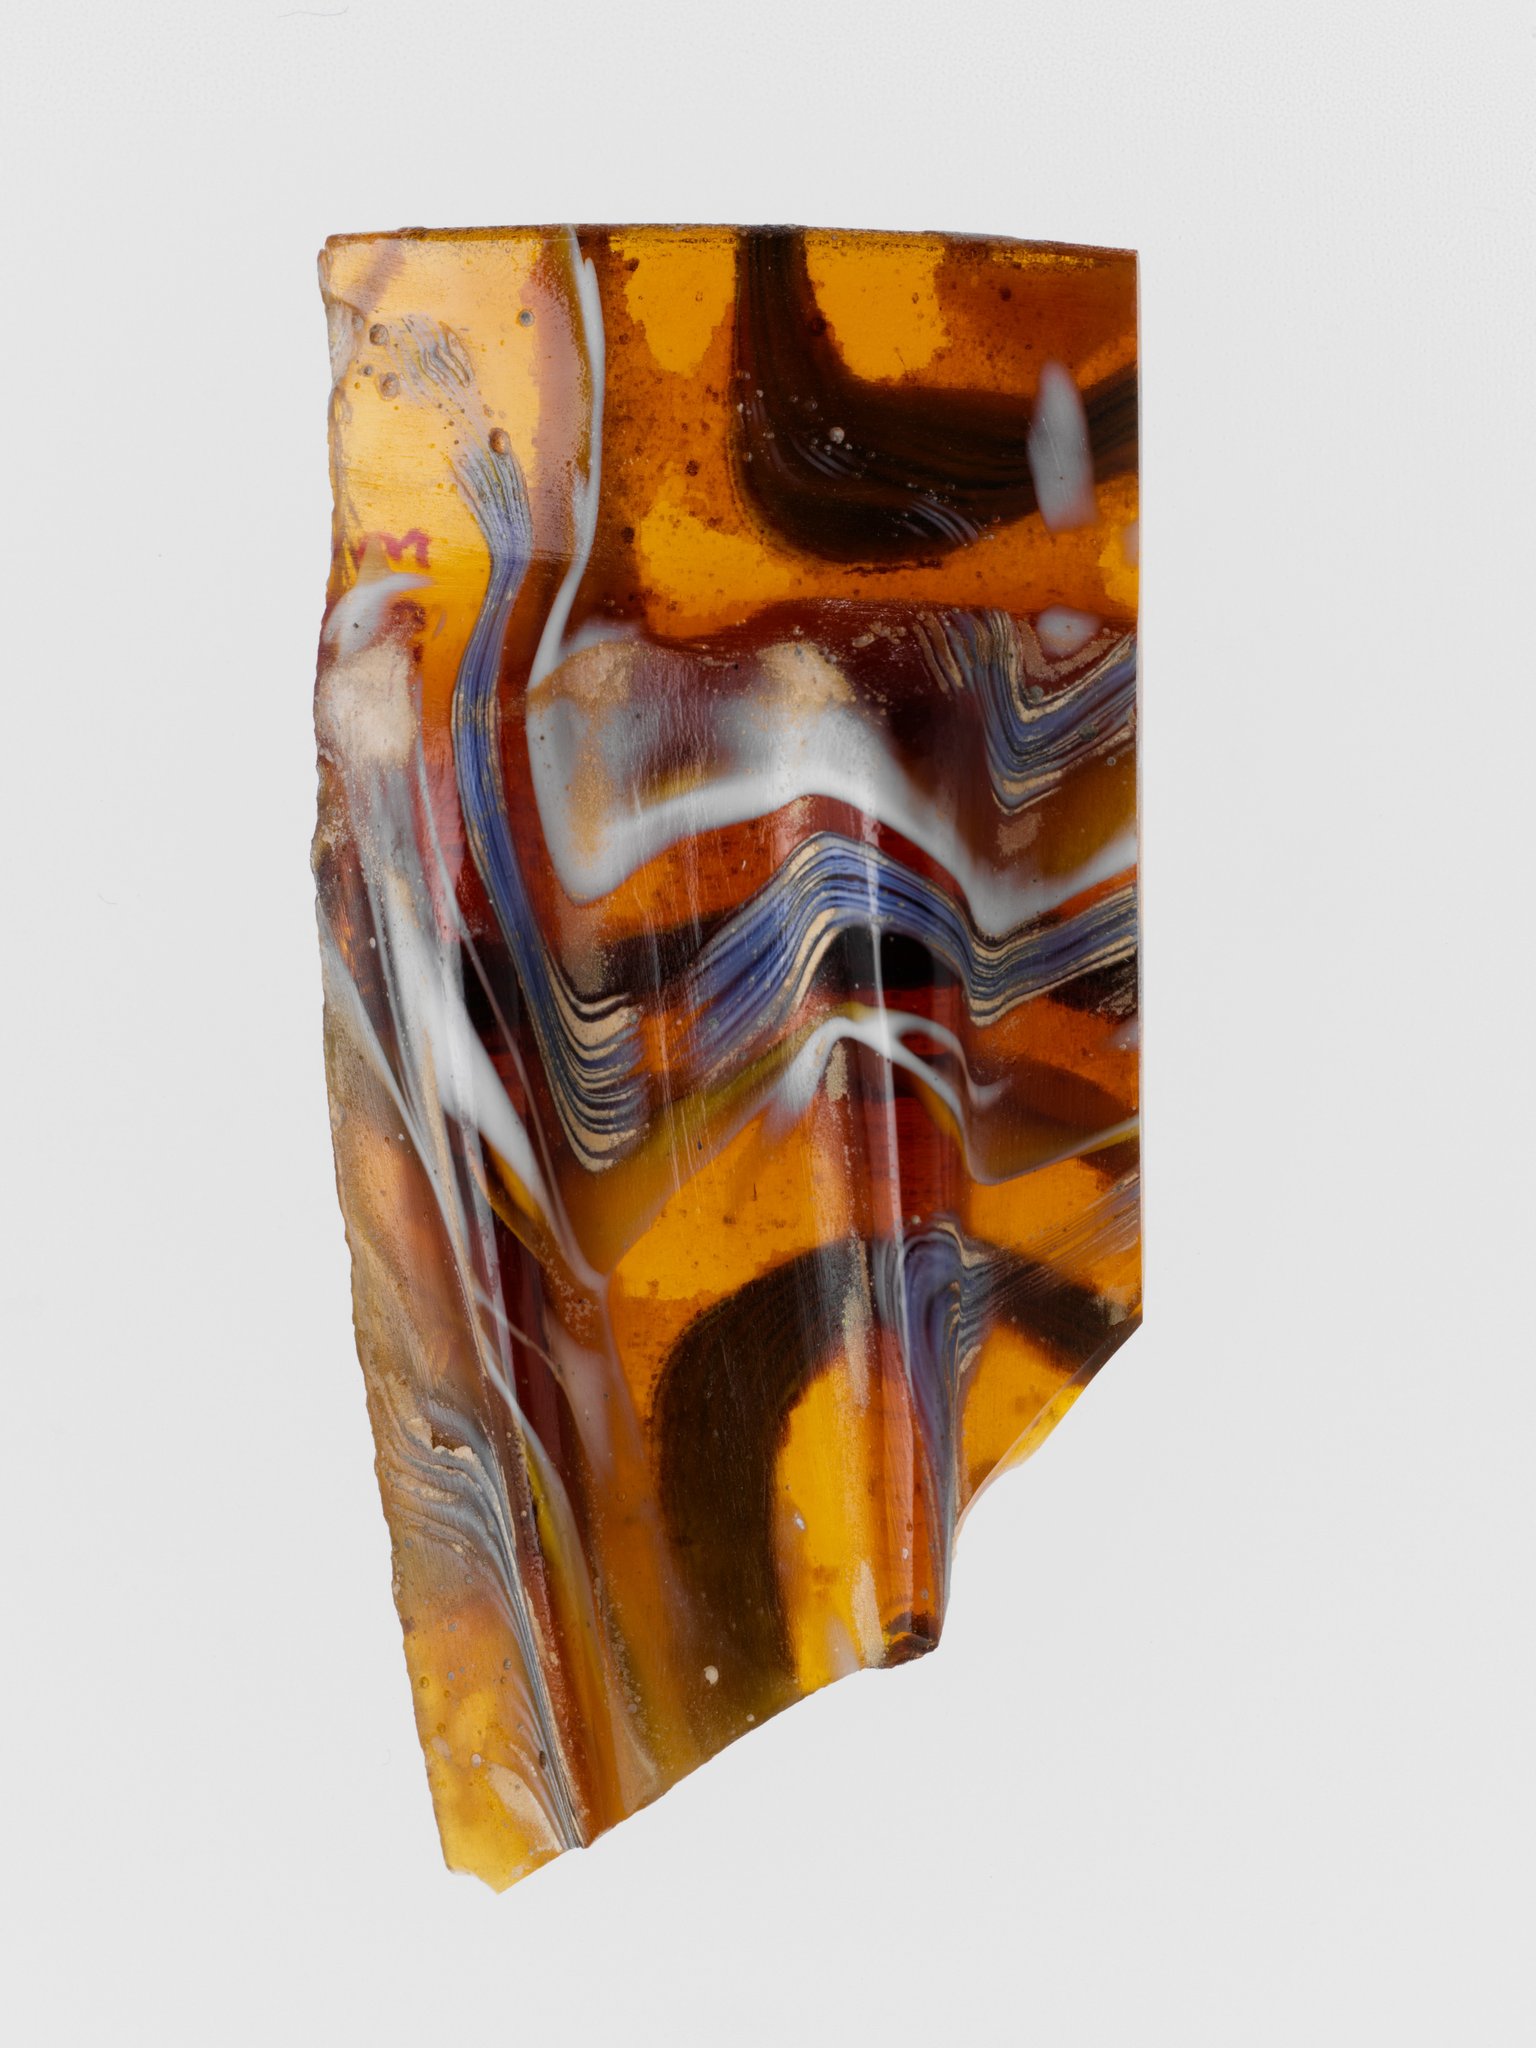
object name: mosaic glass fragment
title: Glass mosaic ribbed bowl fragment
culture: roman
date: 34 BCE-33 CE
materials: glass